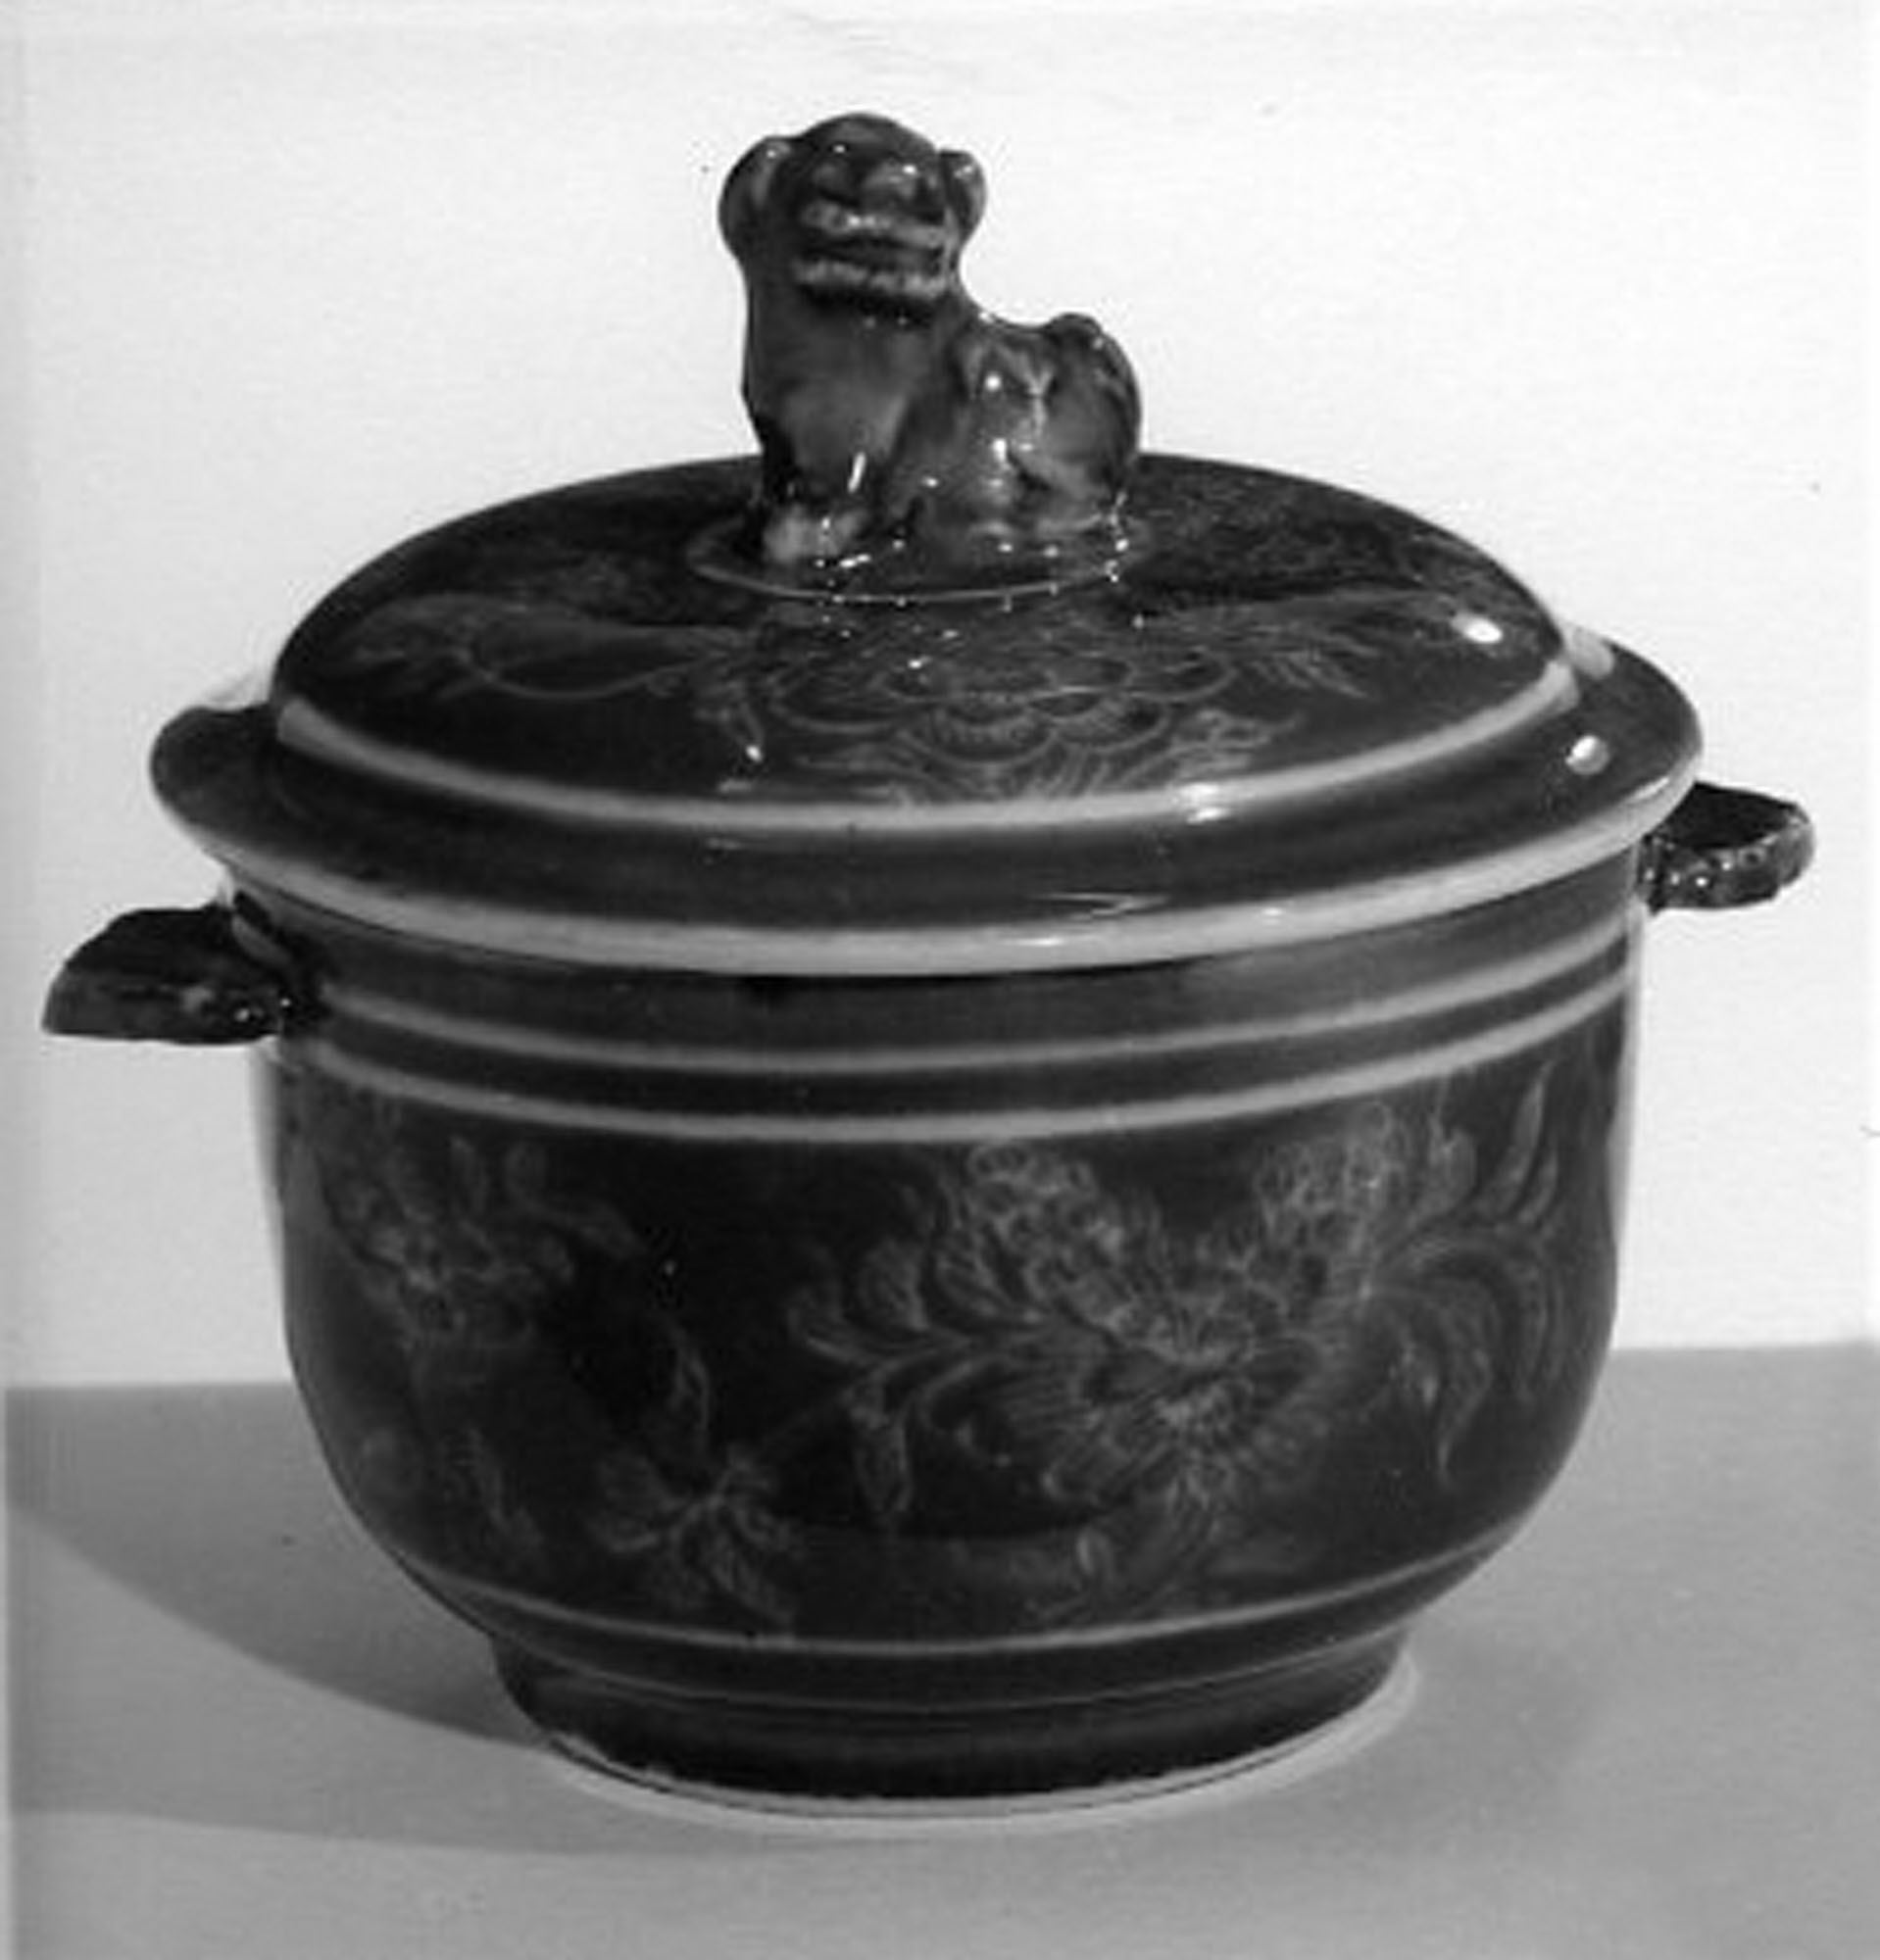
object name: cup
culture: chinese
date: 1667-1733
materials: porcelain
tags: animals,flowers